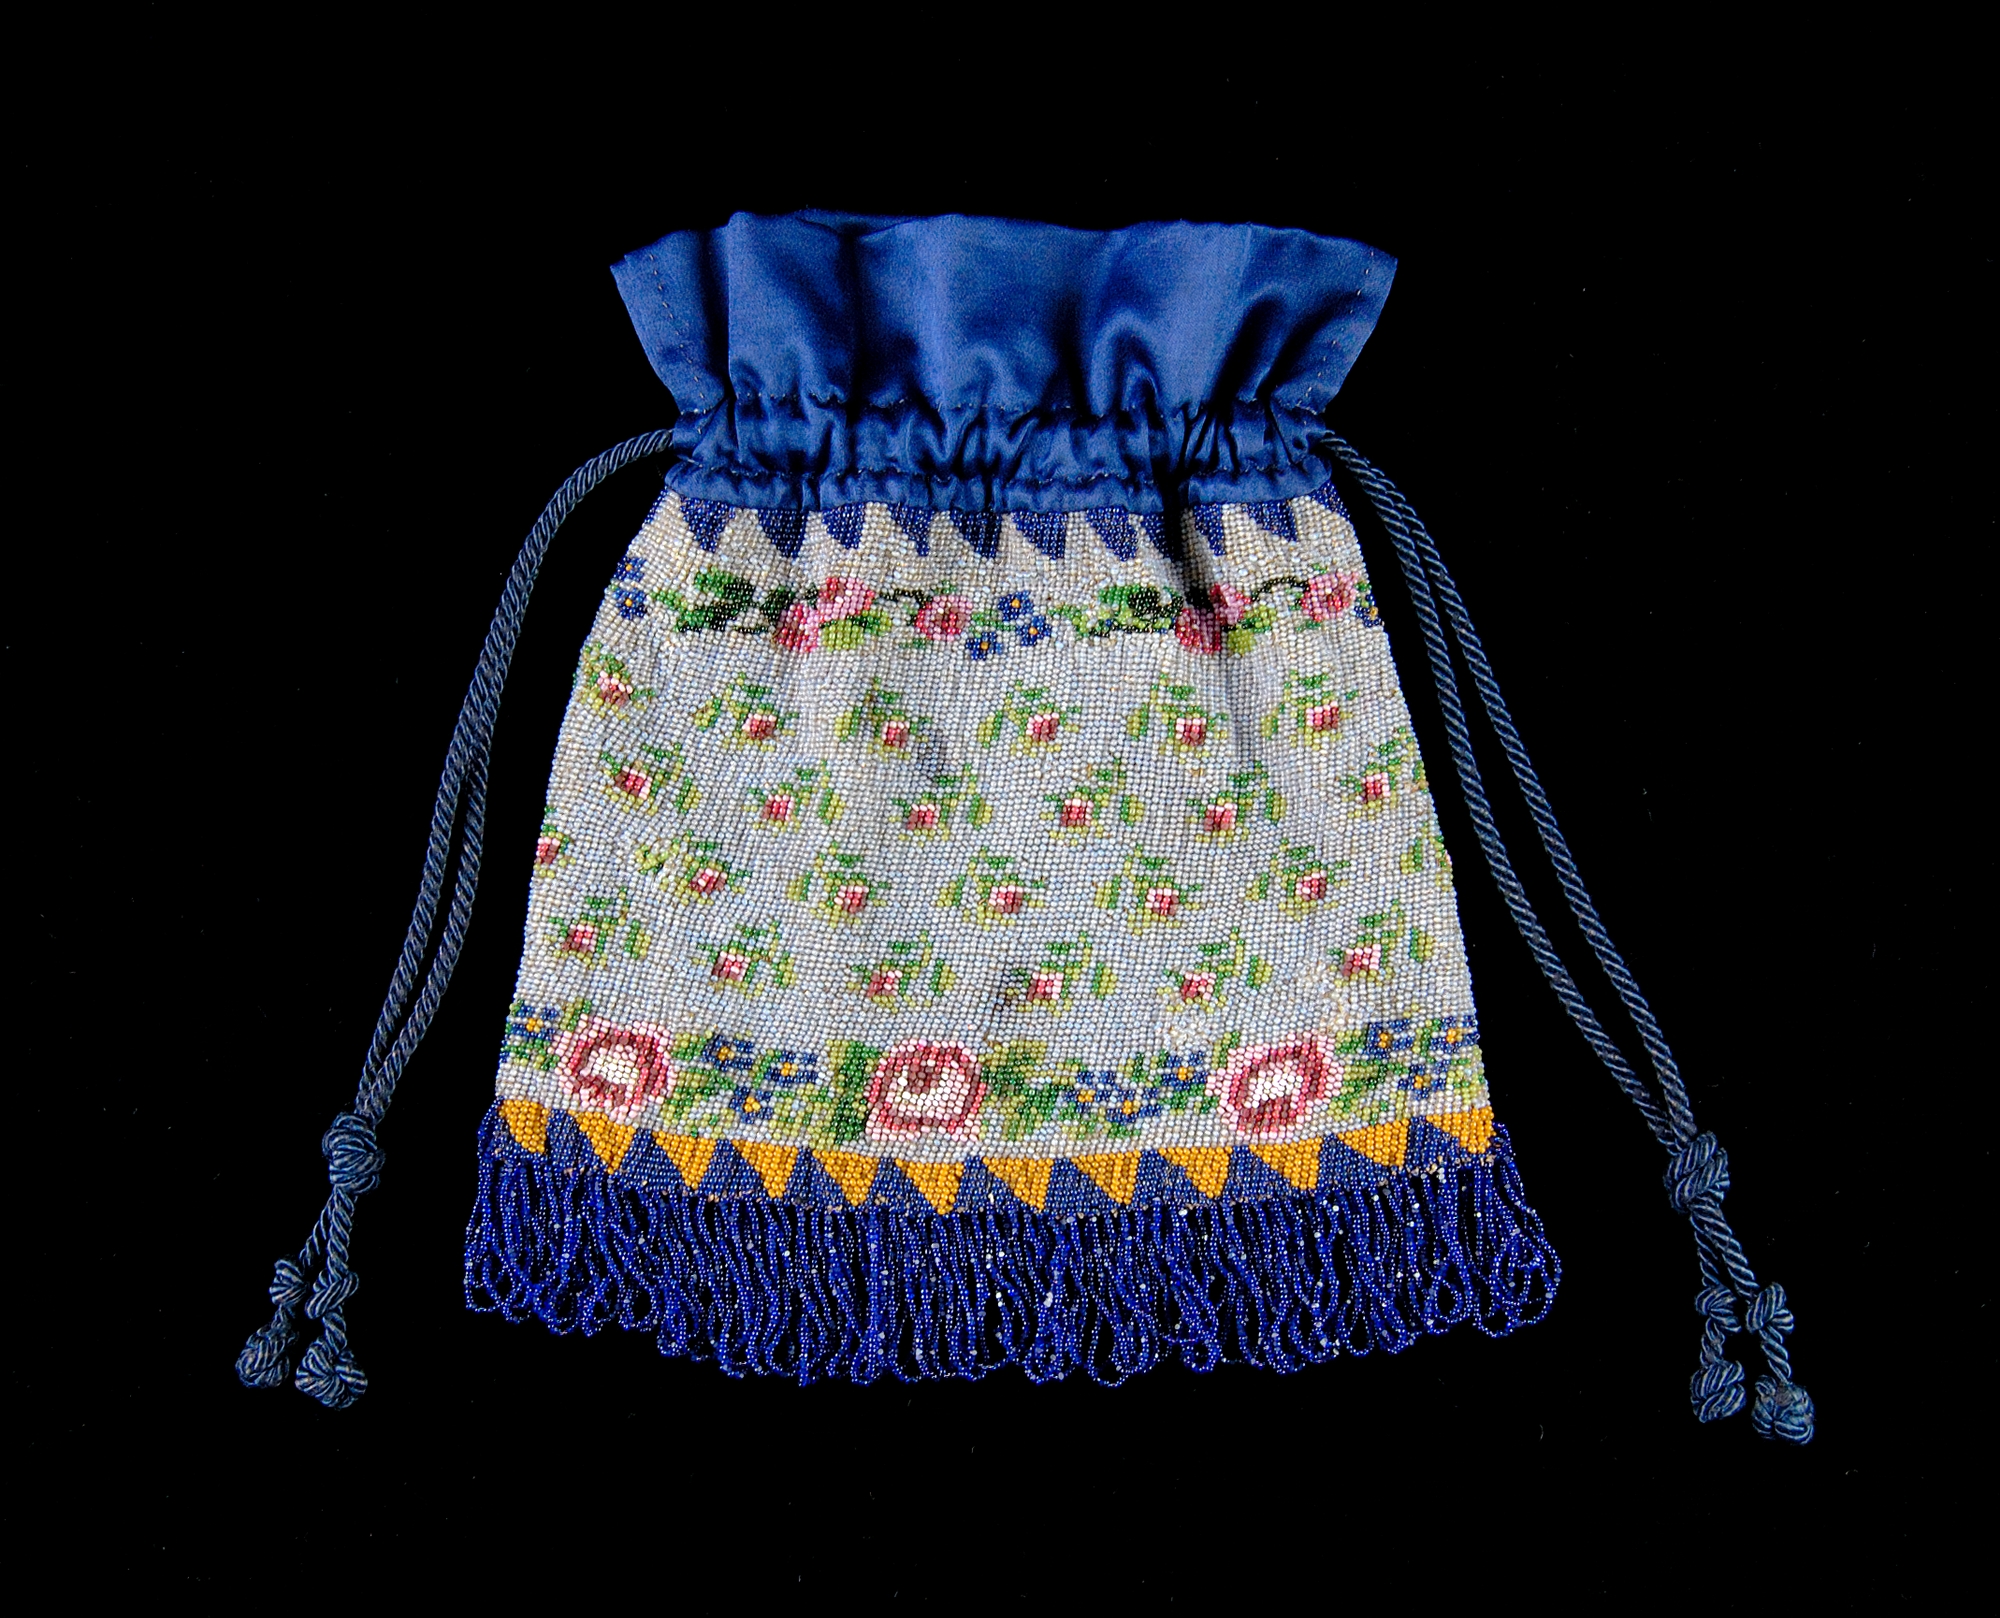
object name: pouch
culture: american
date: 1851-1875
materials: glass, linen, silk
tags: flowers